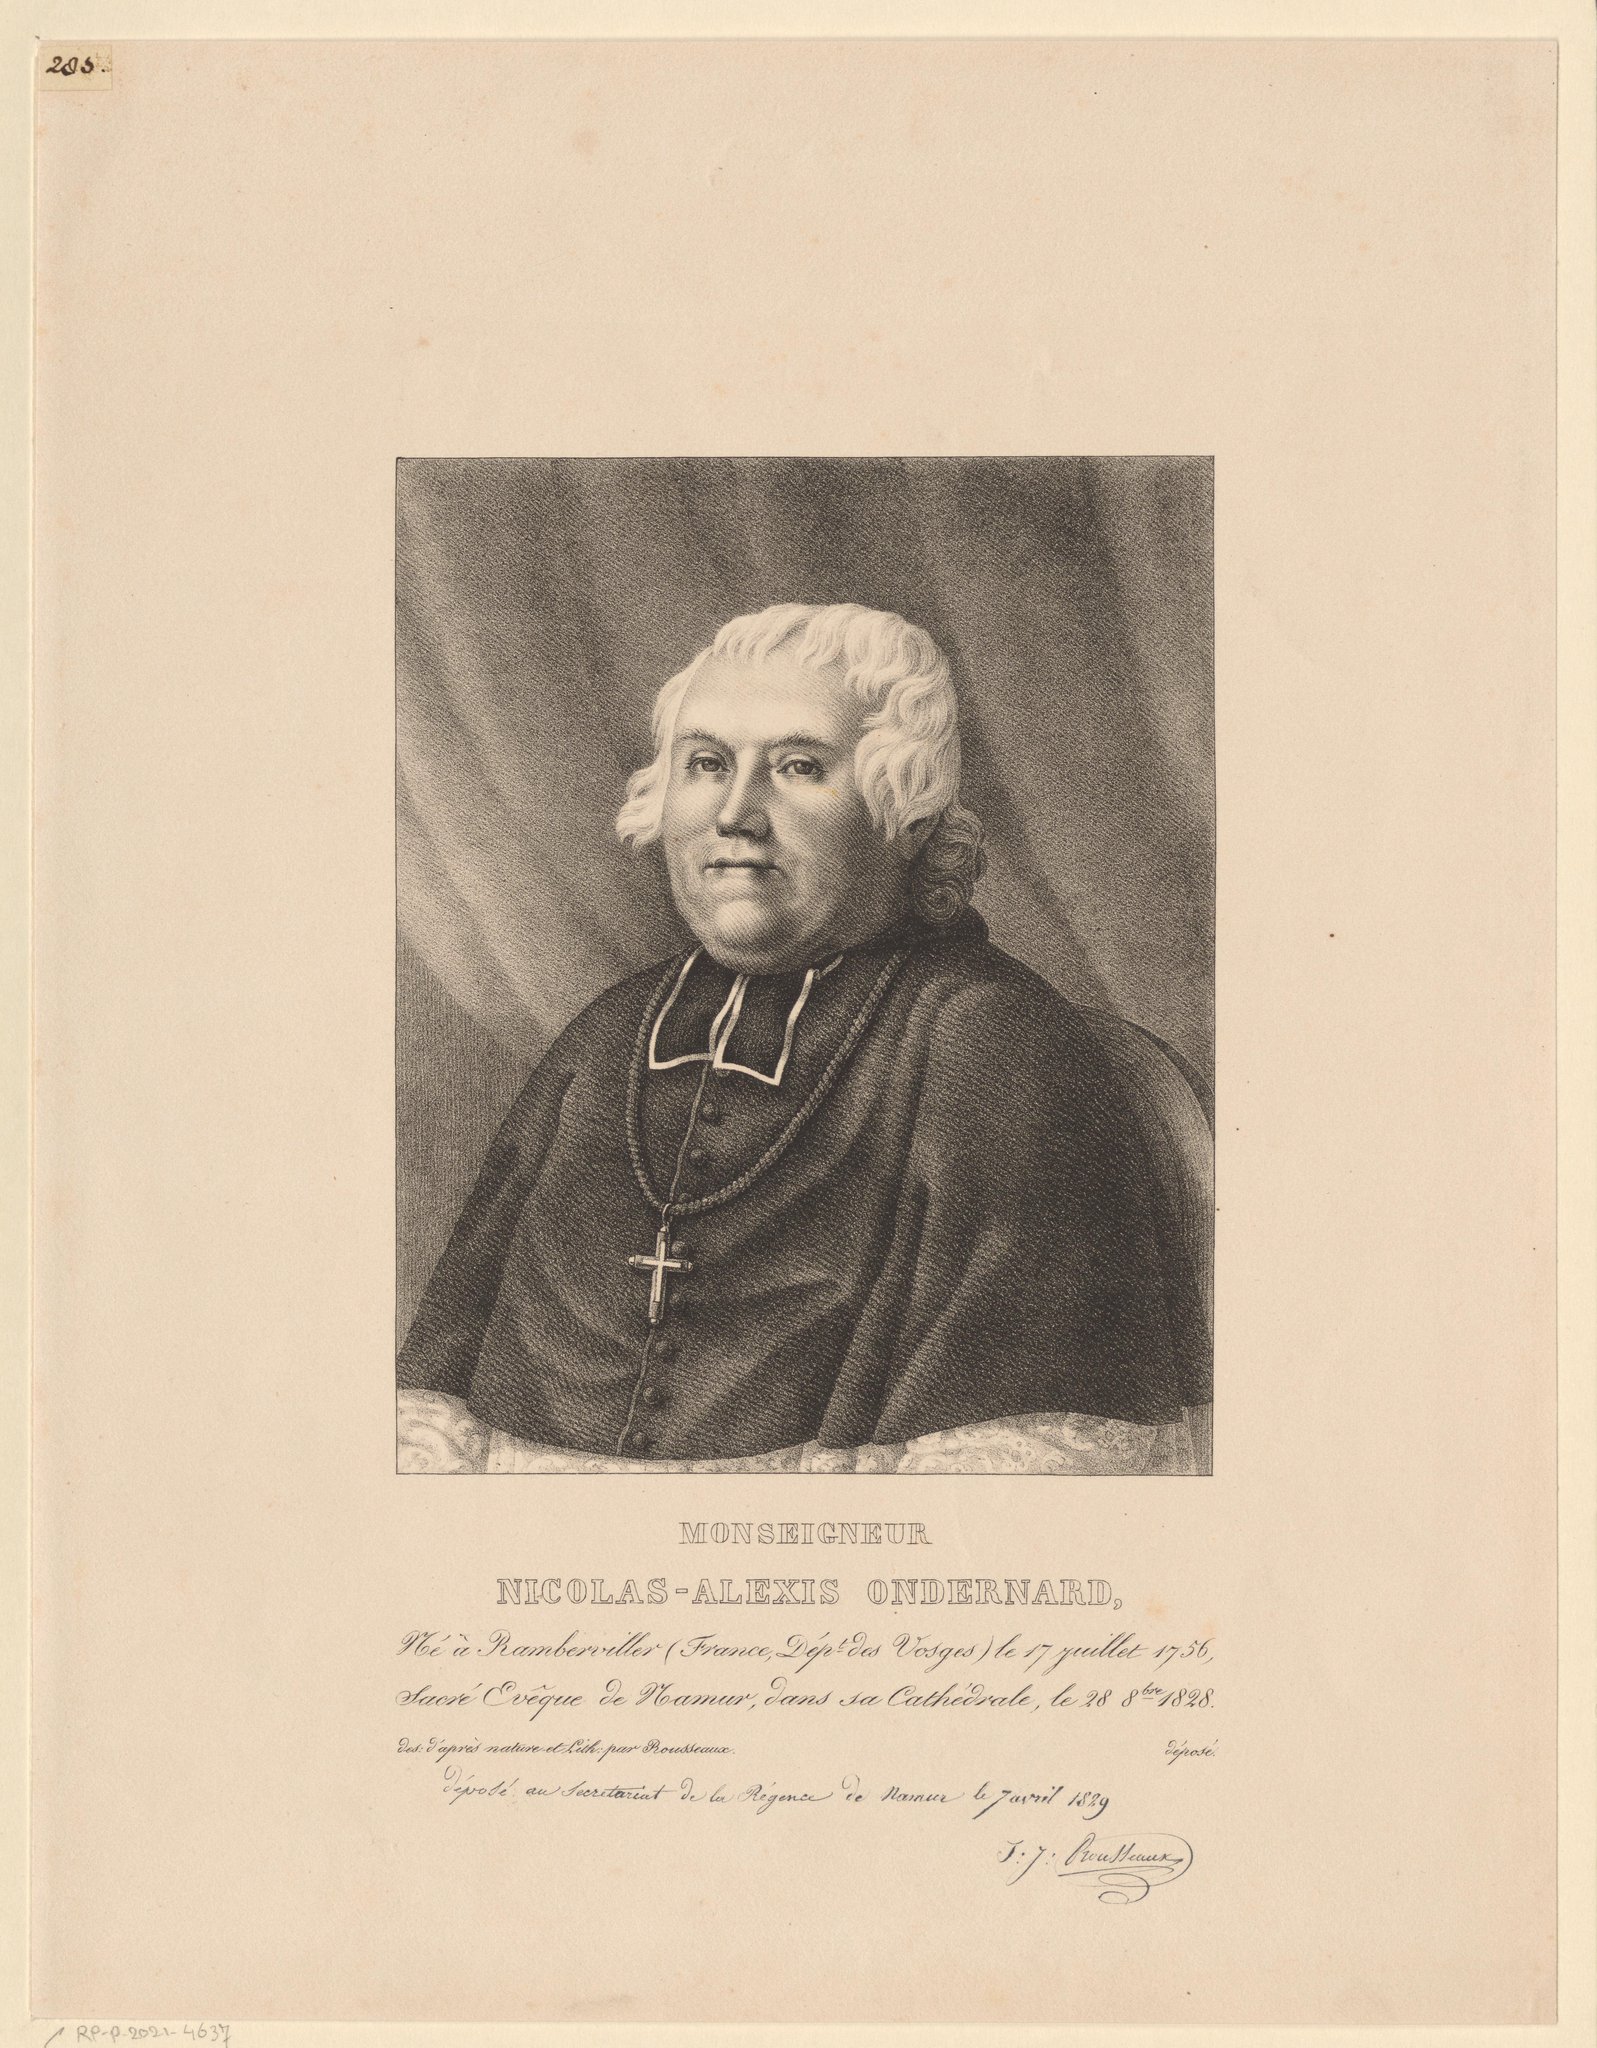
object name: print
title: Portret van Nicolas-Alexis Ondernard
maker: émile alfred rousseaux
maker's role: draughtsman, print maker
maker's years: 1831-1874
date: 1829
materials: paper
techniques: lithograph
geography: paris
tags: priest, historical persons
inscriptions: date